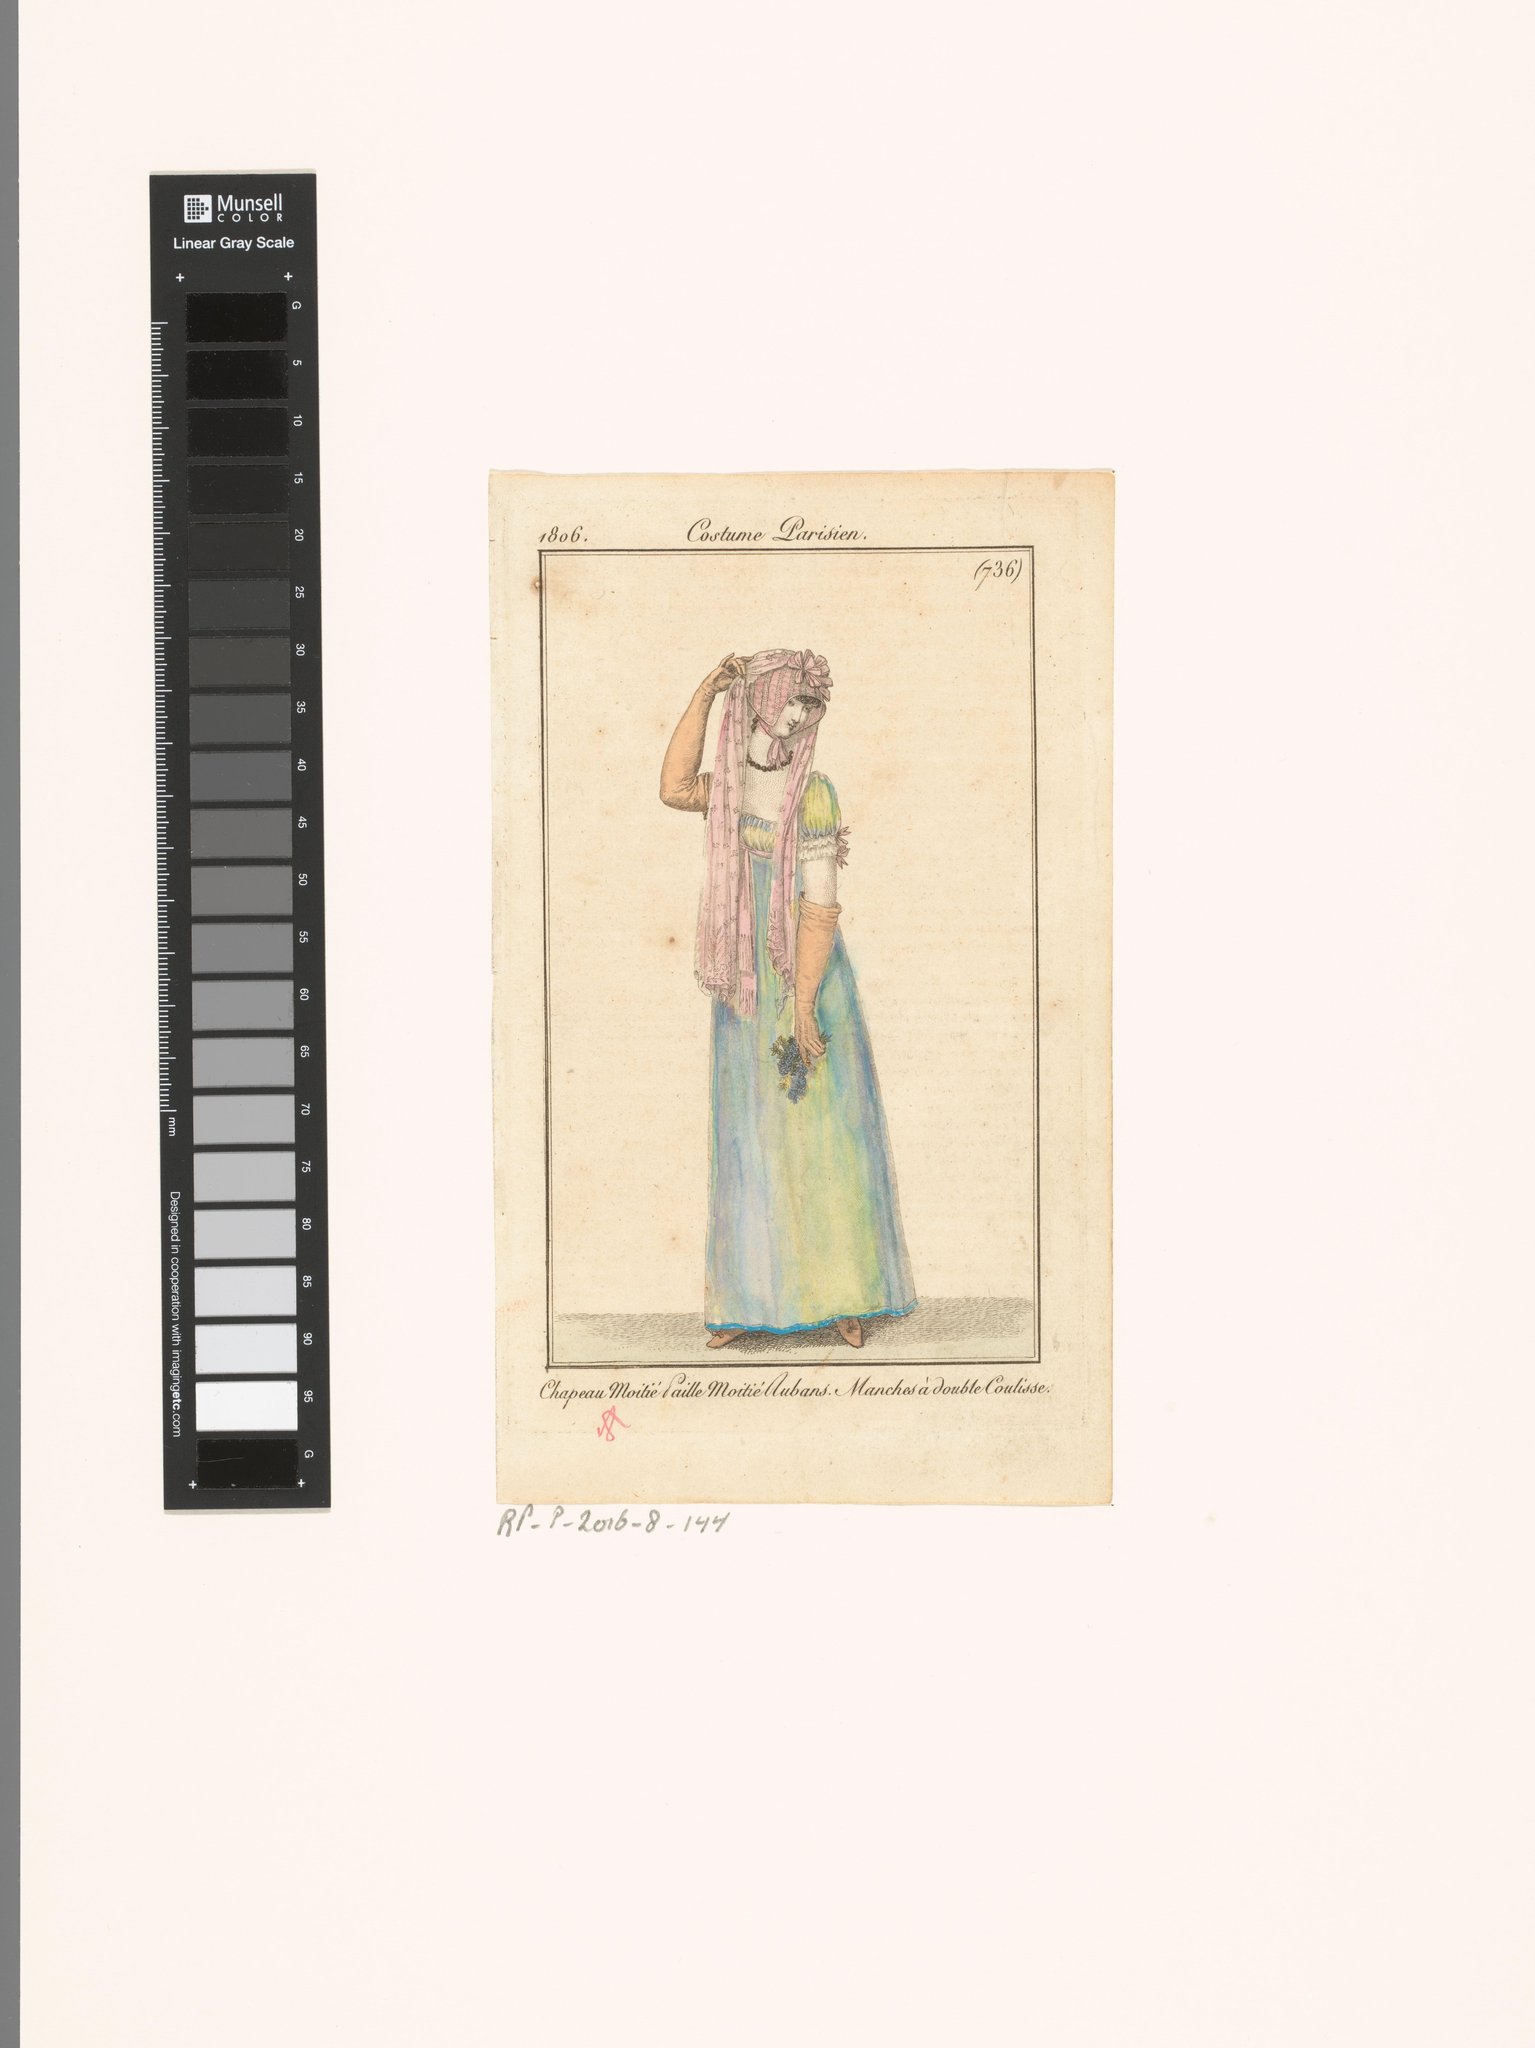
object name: fashion print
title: Journal des Dames et des modes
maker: Anonymous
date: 1806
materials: paper, ink, watercolor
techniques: etching, hand coloring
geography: france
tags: fashion plates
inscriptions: collector's mark: Lugt 2228